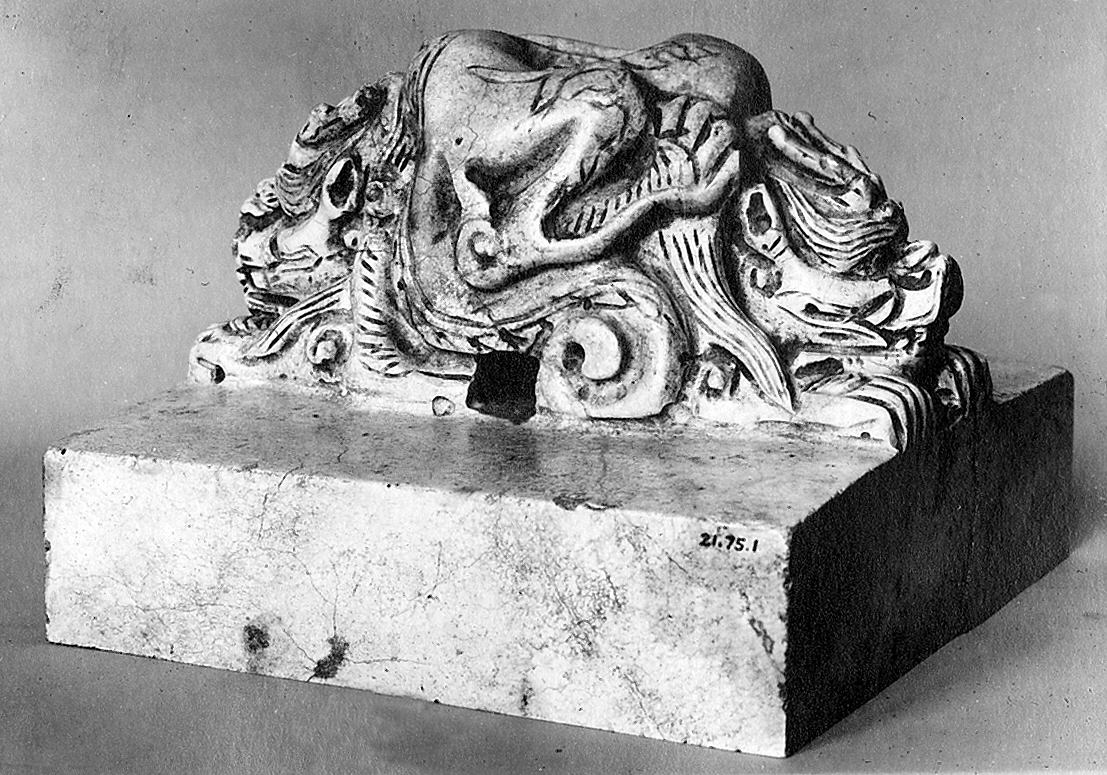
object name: imperial seal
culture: chinese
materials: jade